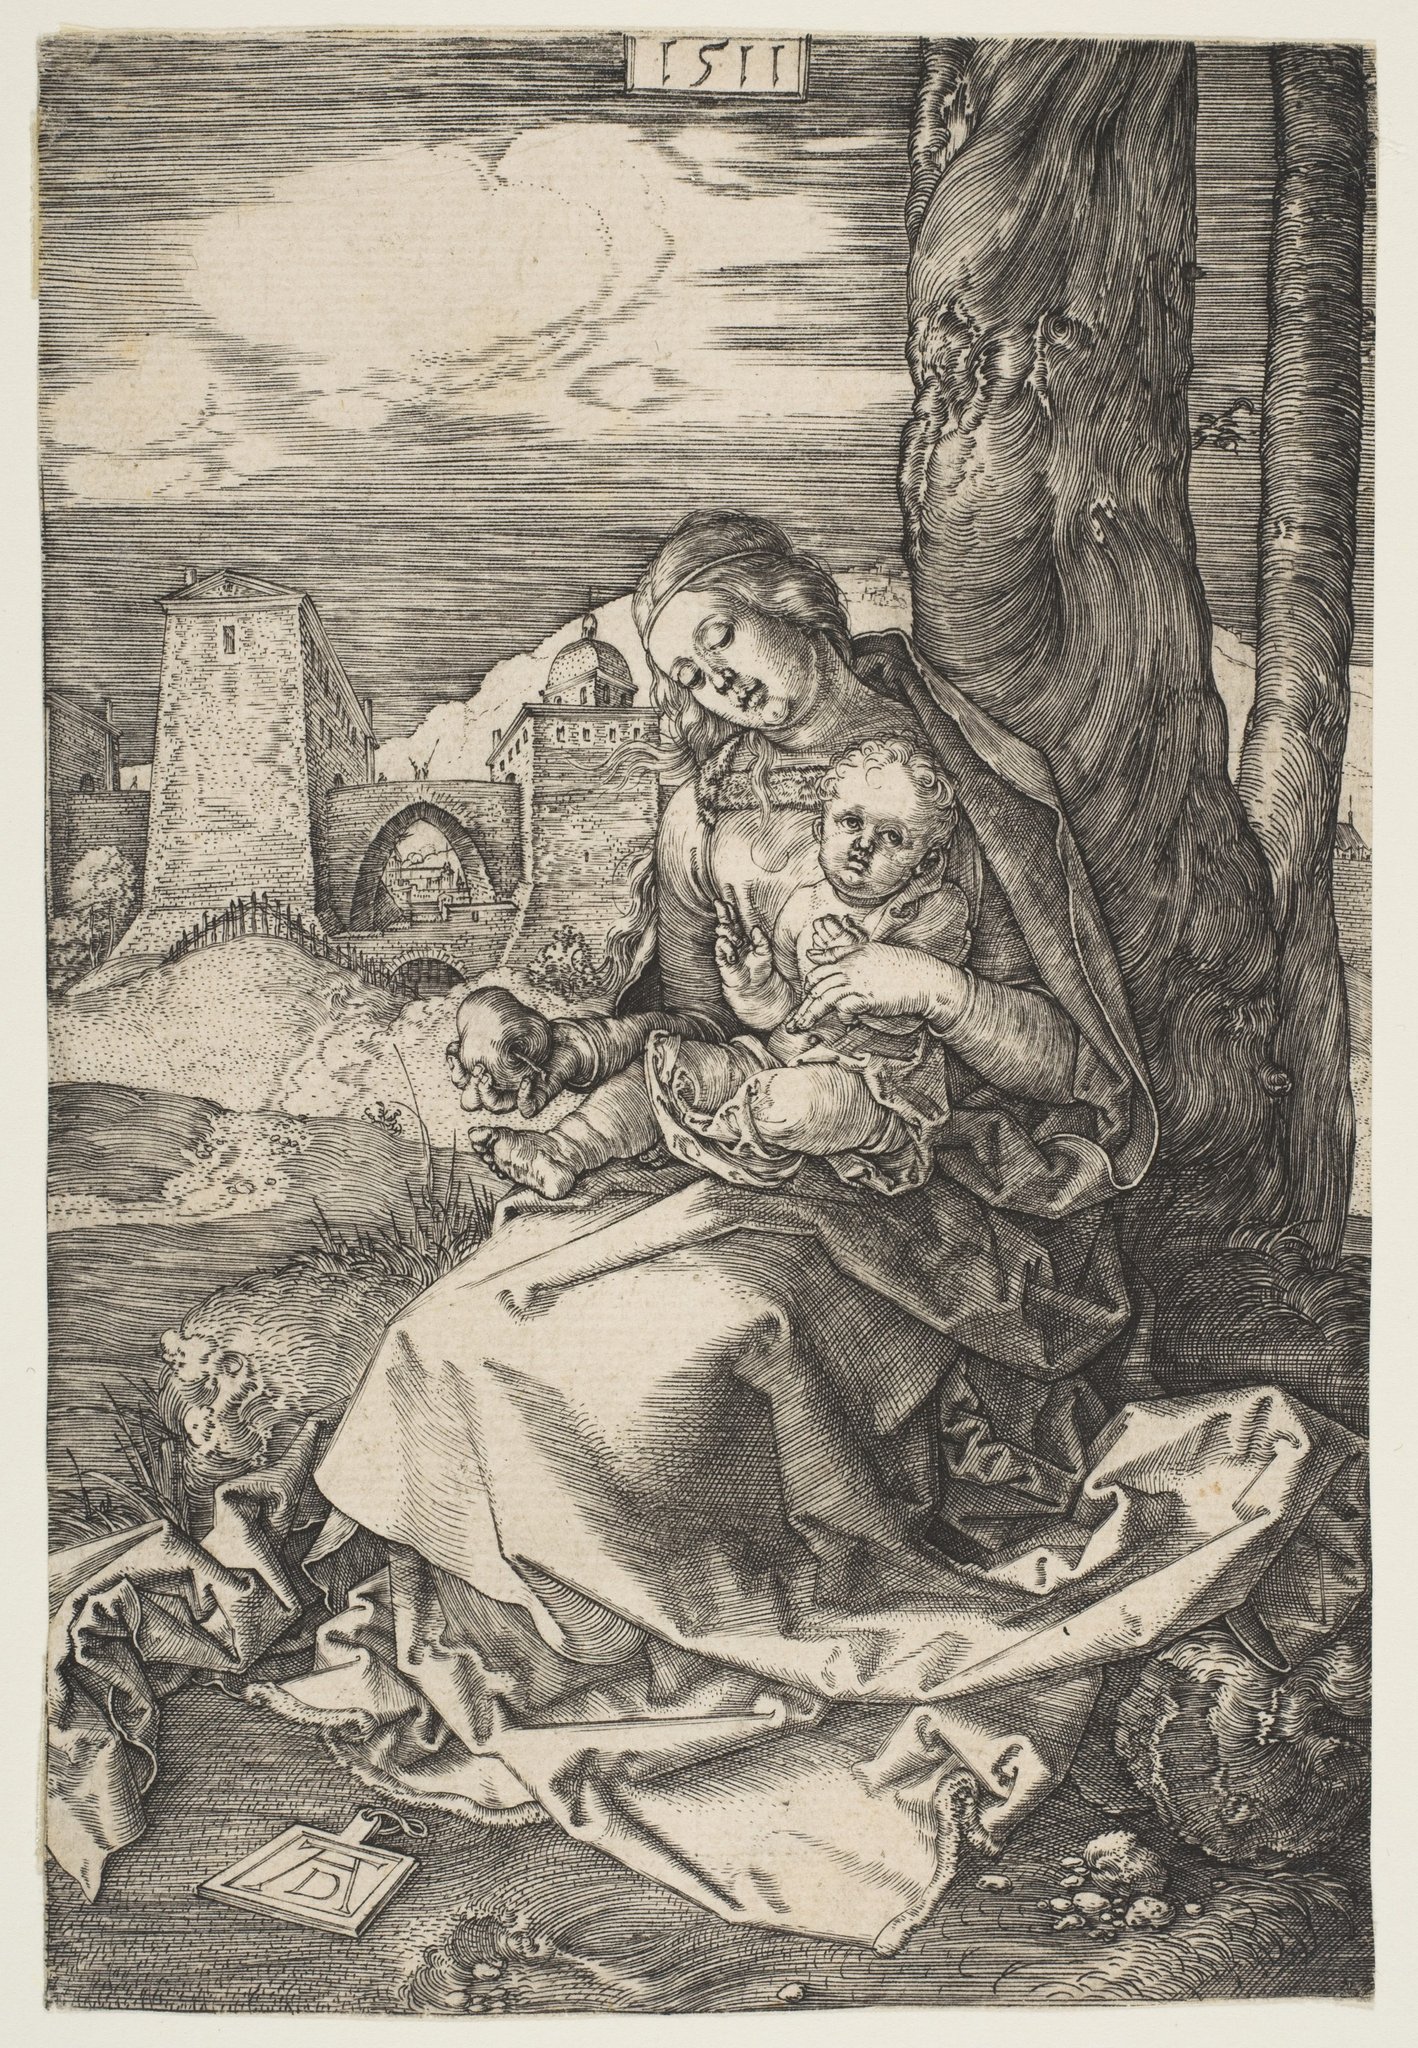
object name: print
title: Virgin and Child with a Pear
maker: albrecht dürer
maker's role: artist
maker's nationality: german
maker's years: 1471-1528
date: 1511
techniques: engraving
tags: pears,madonna and child